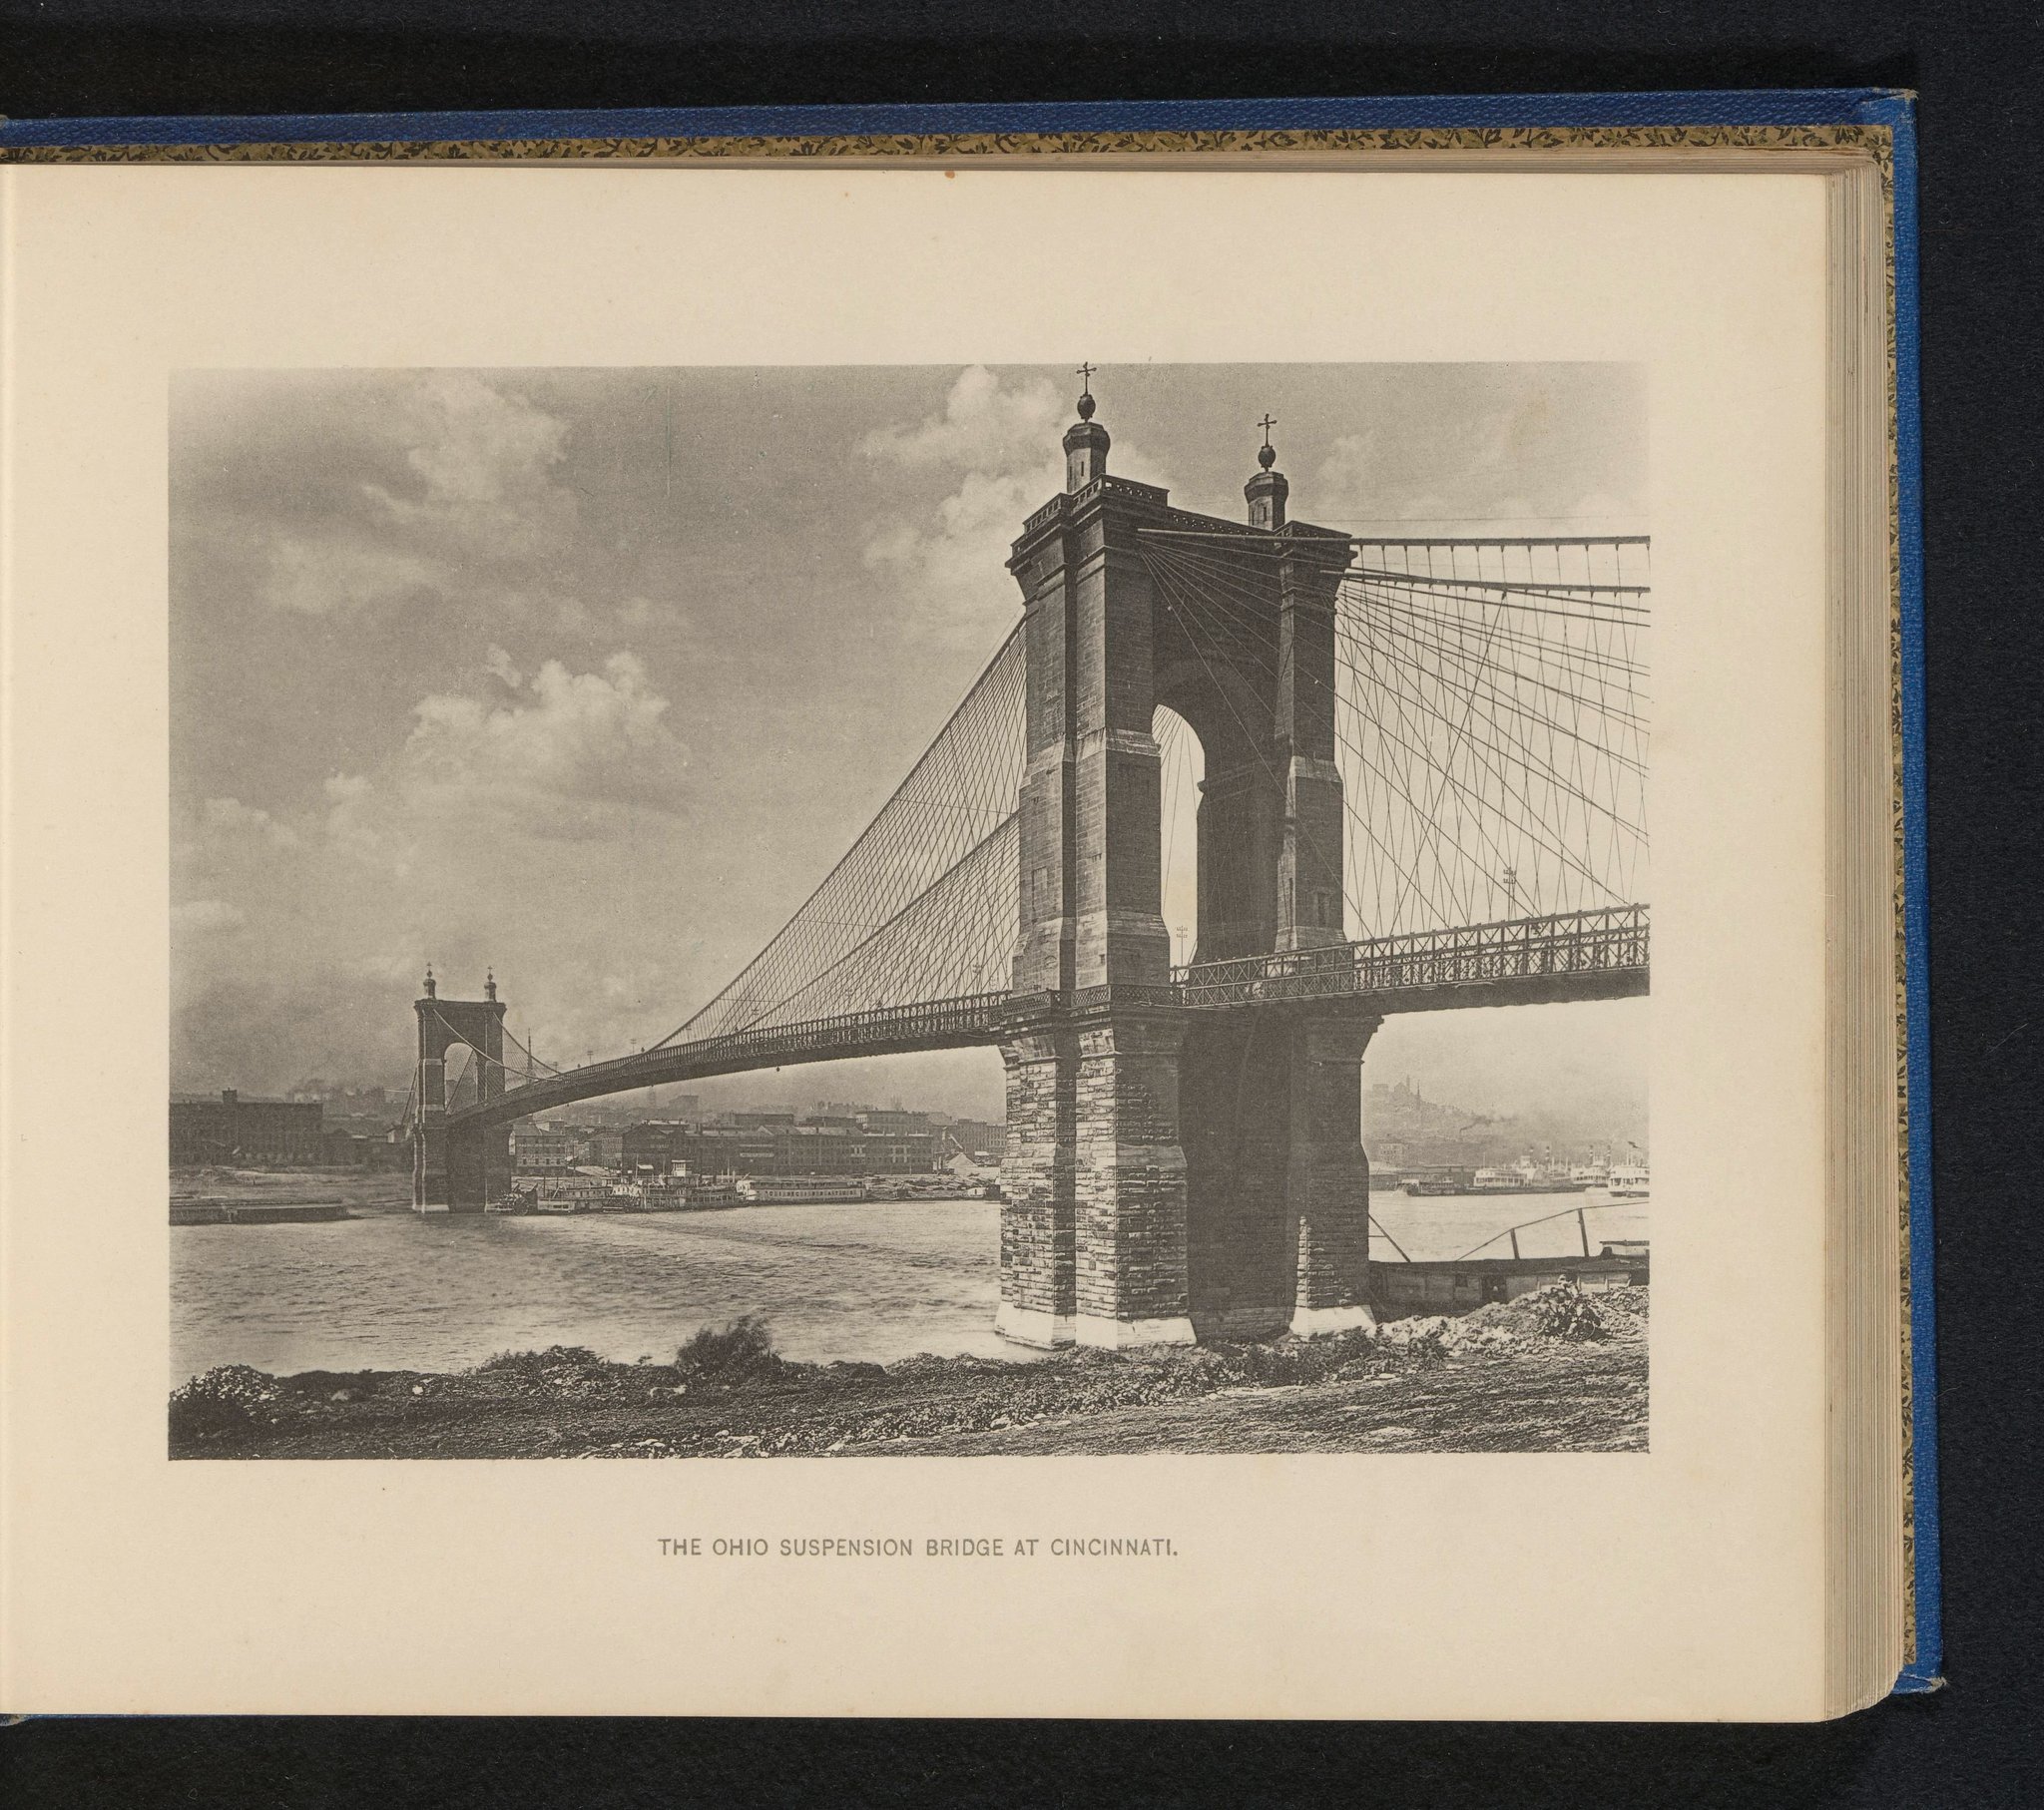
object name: page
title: Gezicht op John A. Roebling Suspension Bridge in Cincinnati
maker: Anonymous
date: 1883-1893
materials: paper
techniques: photograph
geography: cincinnati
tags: suspension bridge, cincinnati